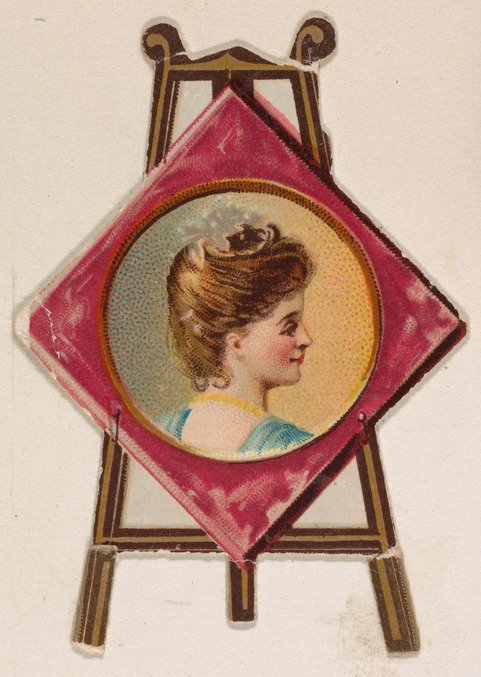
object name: print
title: Painting easel, from the Novelties series (N228, Type 3) issued by Kinney Bros.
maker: kinney brothers tobacco company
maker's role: publisher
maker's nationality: american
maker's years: 1869-2011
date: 1889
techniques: color lithograph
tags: women